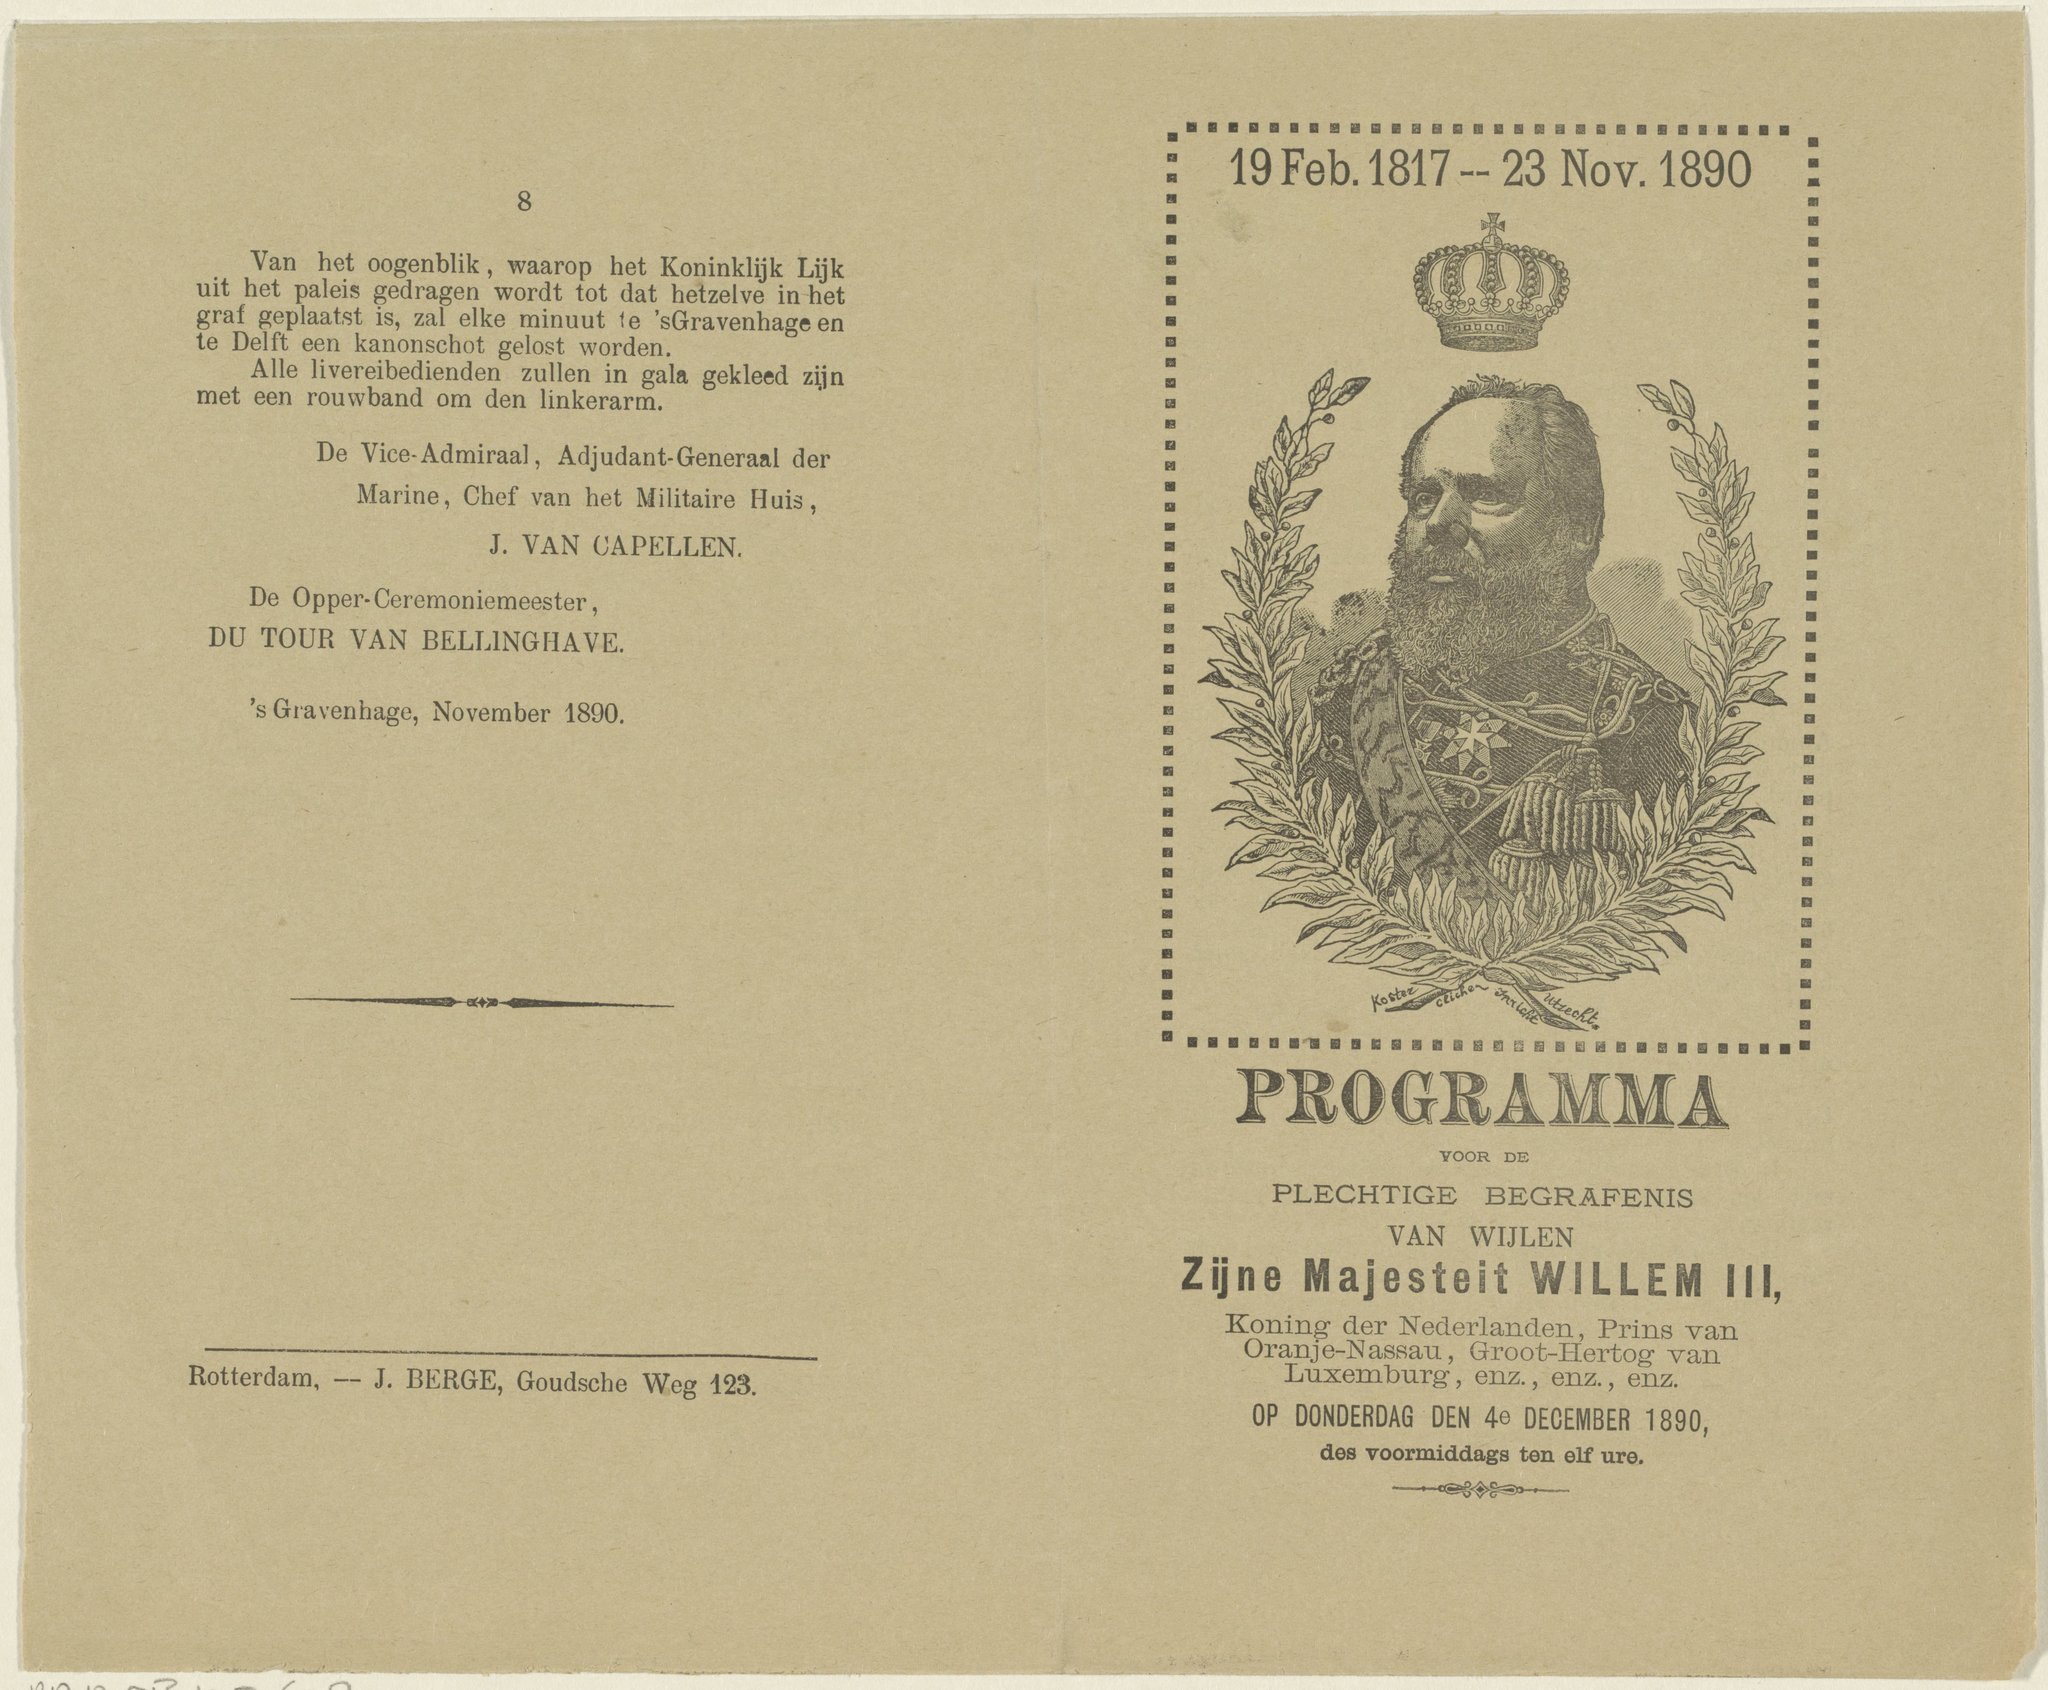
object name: print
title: Programma van de begrafenis van Willem III, koning der Nederlanden, op 4 december 1890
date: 1890-1892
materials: paper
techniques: letterpress printing, engraving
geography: utrecht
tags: brussels, willem iii (koning der nederlanden), funerary ceremonial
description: Programma van de begrafenis van Willem III op 4 december 1890. In het midden een portret van Willem III in een ovaal van oranjetakken. Midden boven een kroon. Daar omheen Nederlandse tekst in boekdruk.